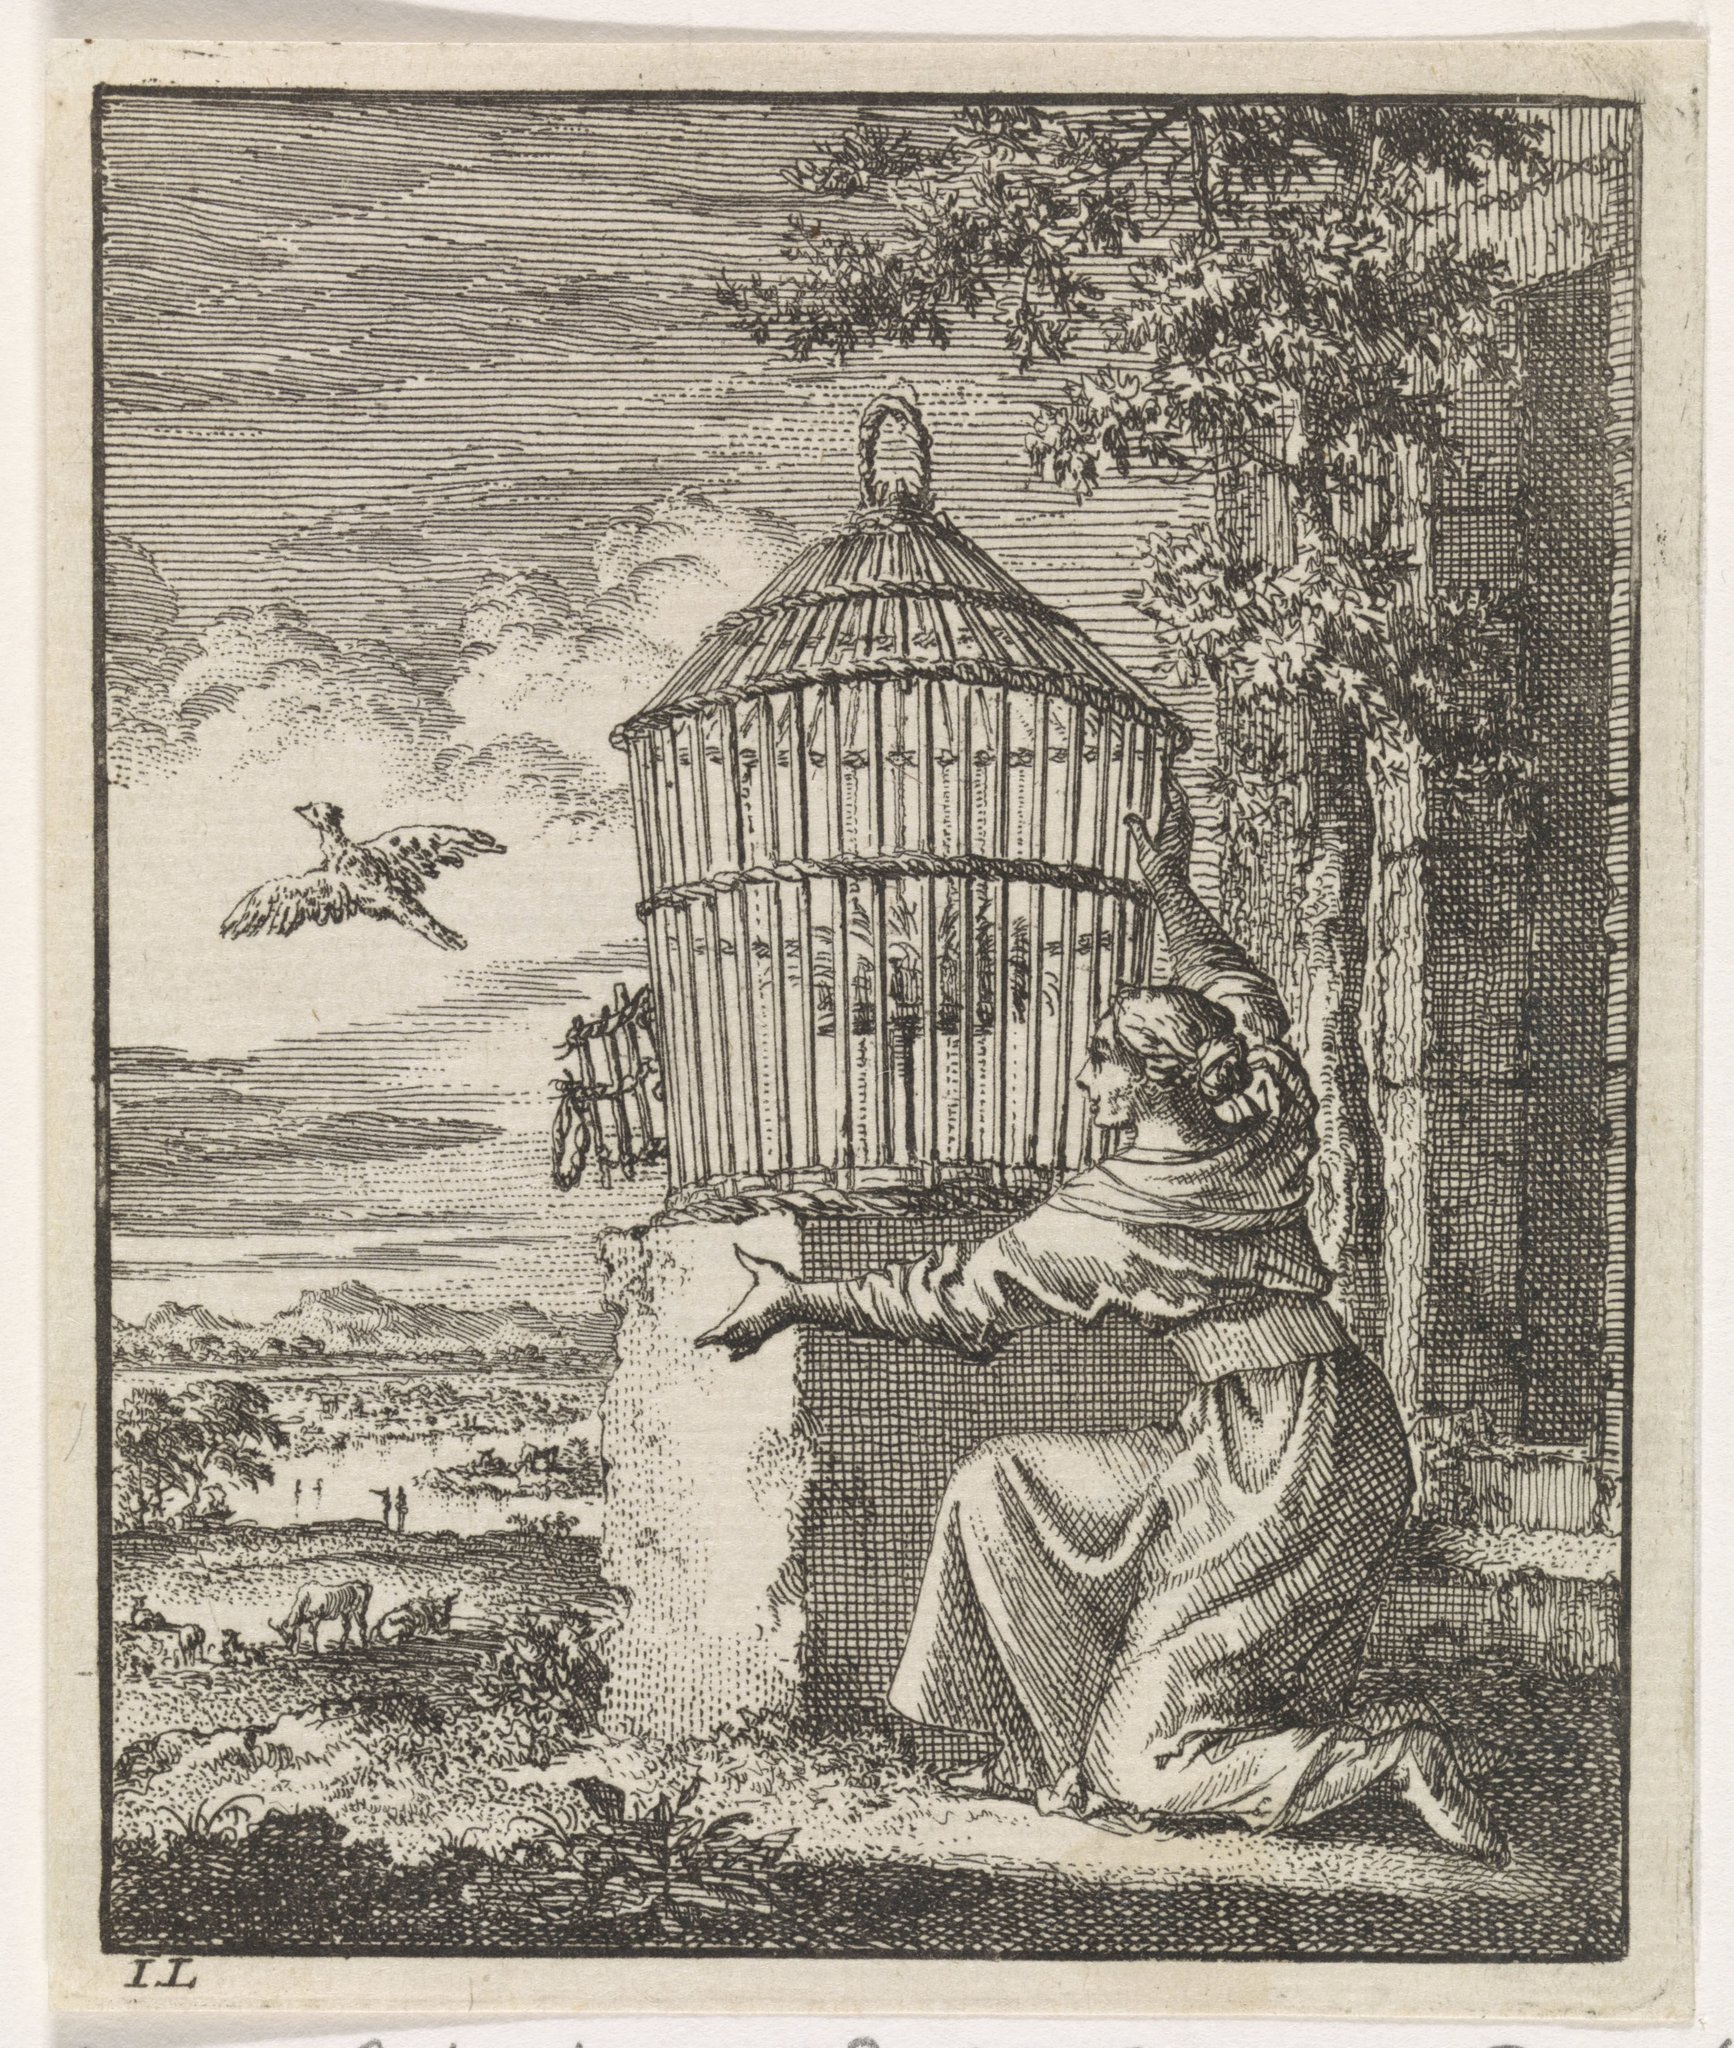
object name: book illustration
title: Vrouw bevrijdt een vogel uit een kooi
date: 1704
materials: paper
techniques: etching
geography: amsterdam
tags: bird in a cage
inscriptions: collector's mark: Lugt 2228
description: Illustratie uit: Luyken, Jan. De zedelyke en stichtelyke gezangen. Amsterdam: Wed. Pieter Arentsz (II) en Cornelis van der Sys, 1704, p. 111.